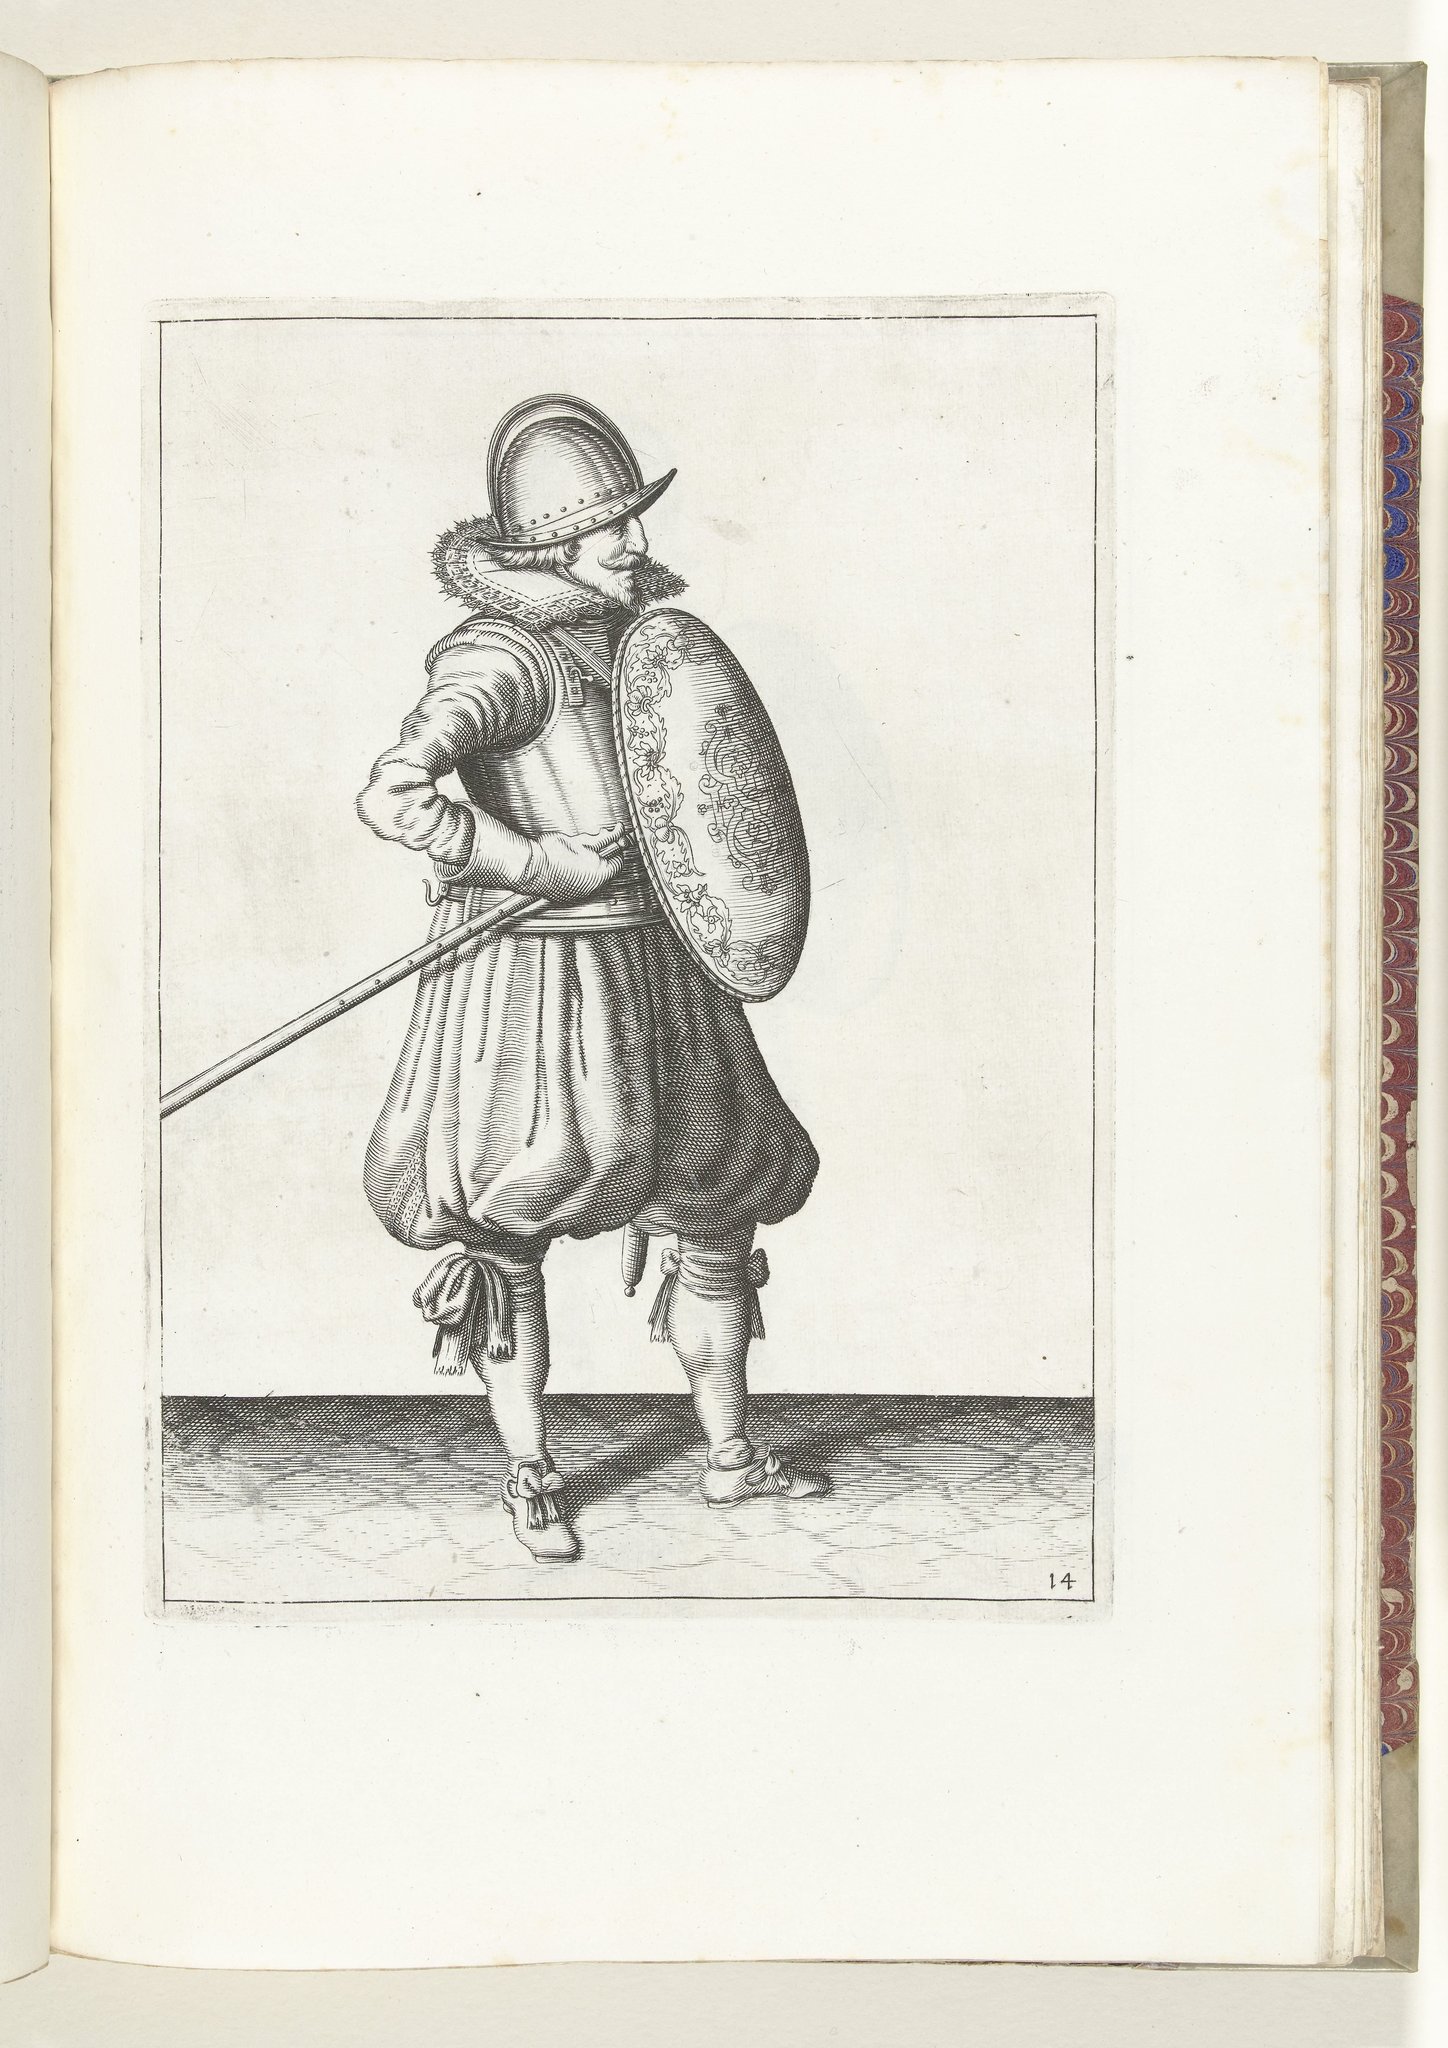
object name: print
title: De Nassausche Wapen-Handelinge, van Schilt, Spies, Rappier ende Targe : beyde figuerlick afgebeelt, ende gestelt na de nieu ordening [van] (...) Maurits van Nassau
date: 1616-1618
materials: paper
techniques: engraving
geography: northern netherlands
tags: maurice (prince of orange), handling of weapons ~ military training, weapons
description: Illustratie in: Adam van Breen, De Nassausche Wapen-Handelinge, van Schilt, Spies, Rappier ende Targe : beyde figuerlick afgebeelt, ende gestelt na de nieu ordening [van] ... Maurits van Nassau, 's-Gravenhage, [Aert Meuris] 1618, plaat nr. 14. In het exemplaar in de collectie van de Rijksmuseum Research Library (326 F 22).